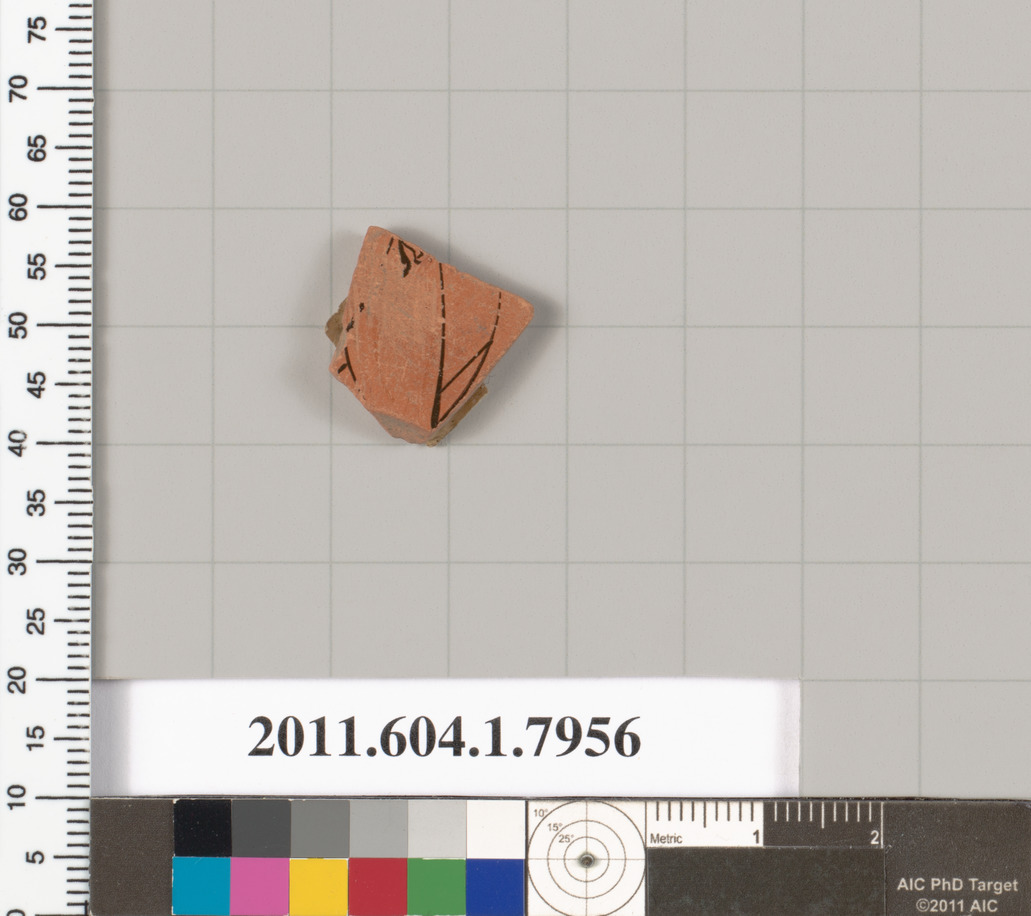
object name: kylix fragment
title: Terracotta fragment of a kylix (drinking cup)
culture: greek, attic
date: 460-450 BCE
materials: terracotta